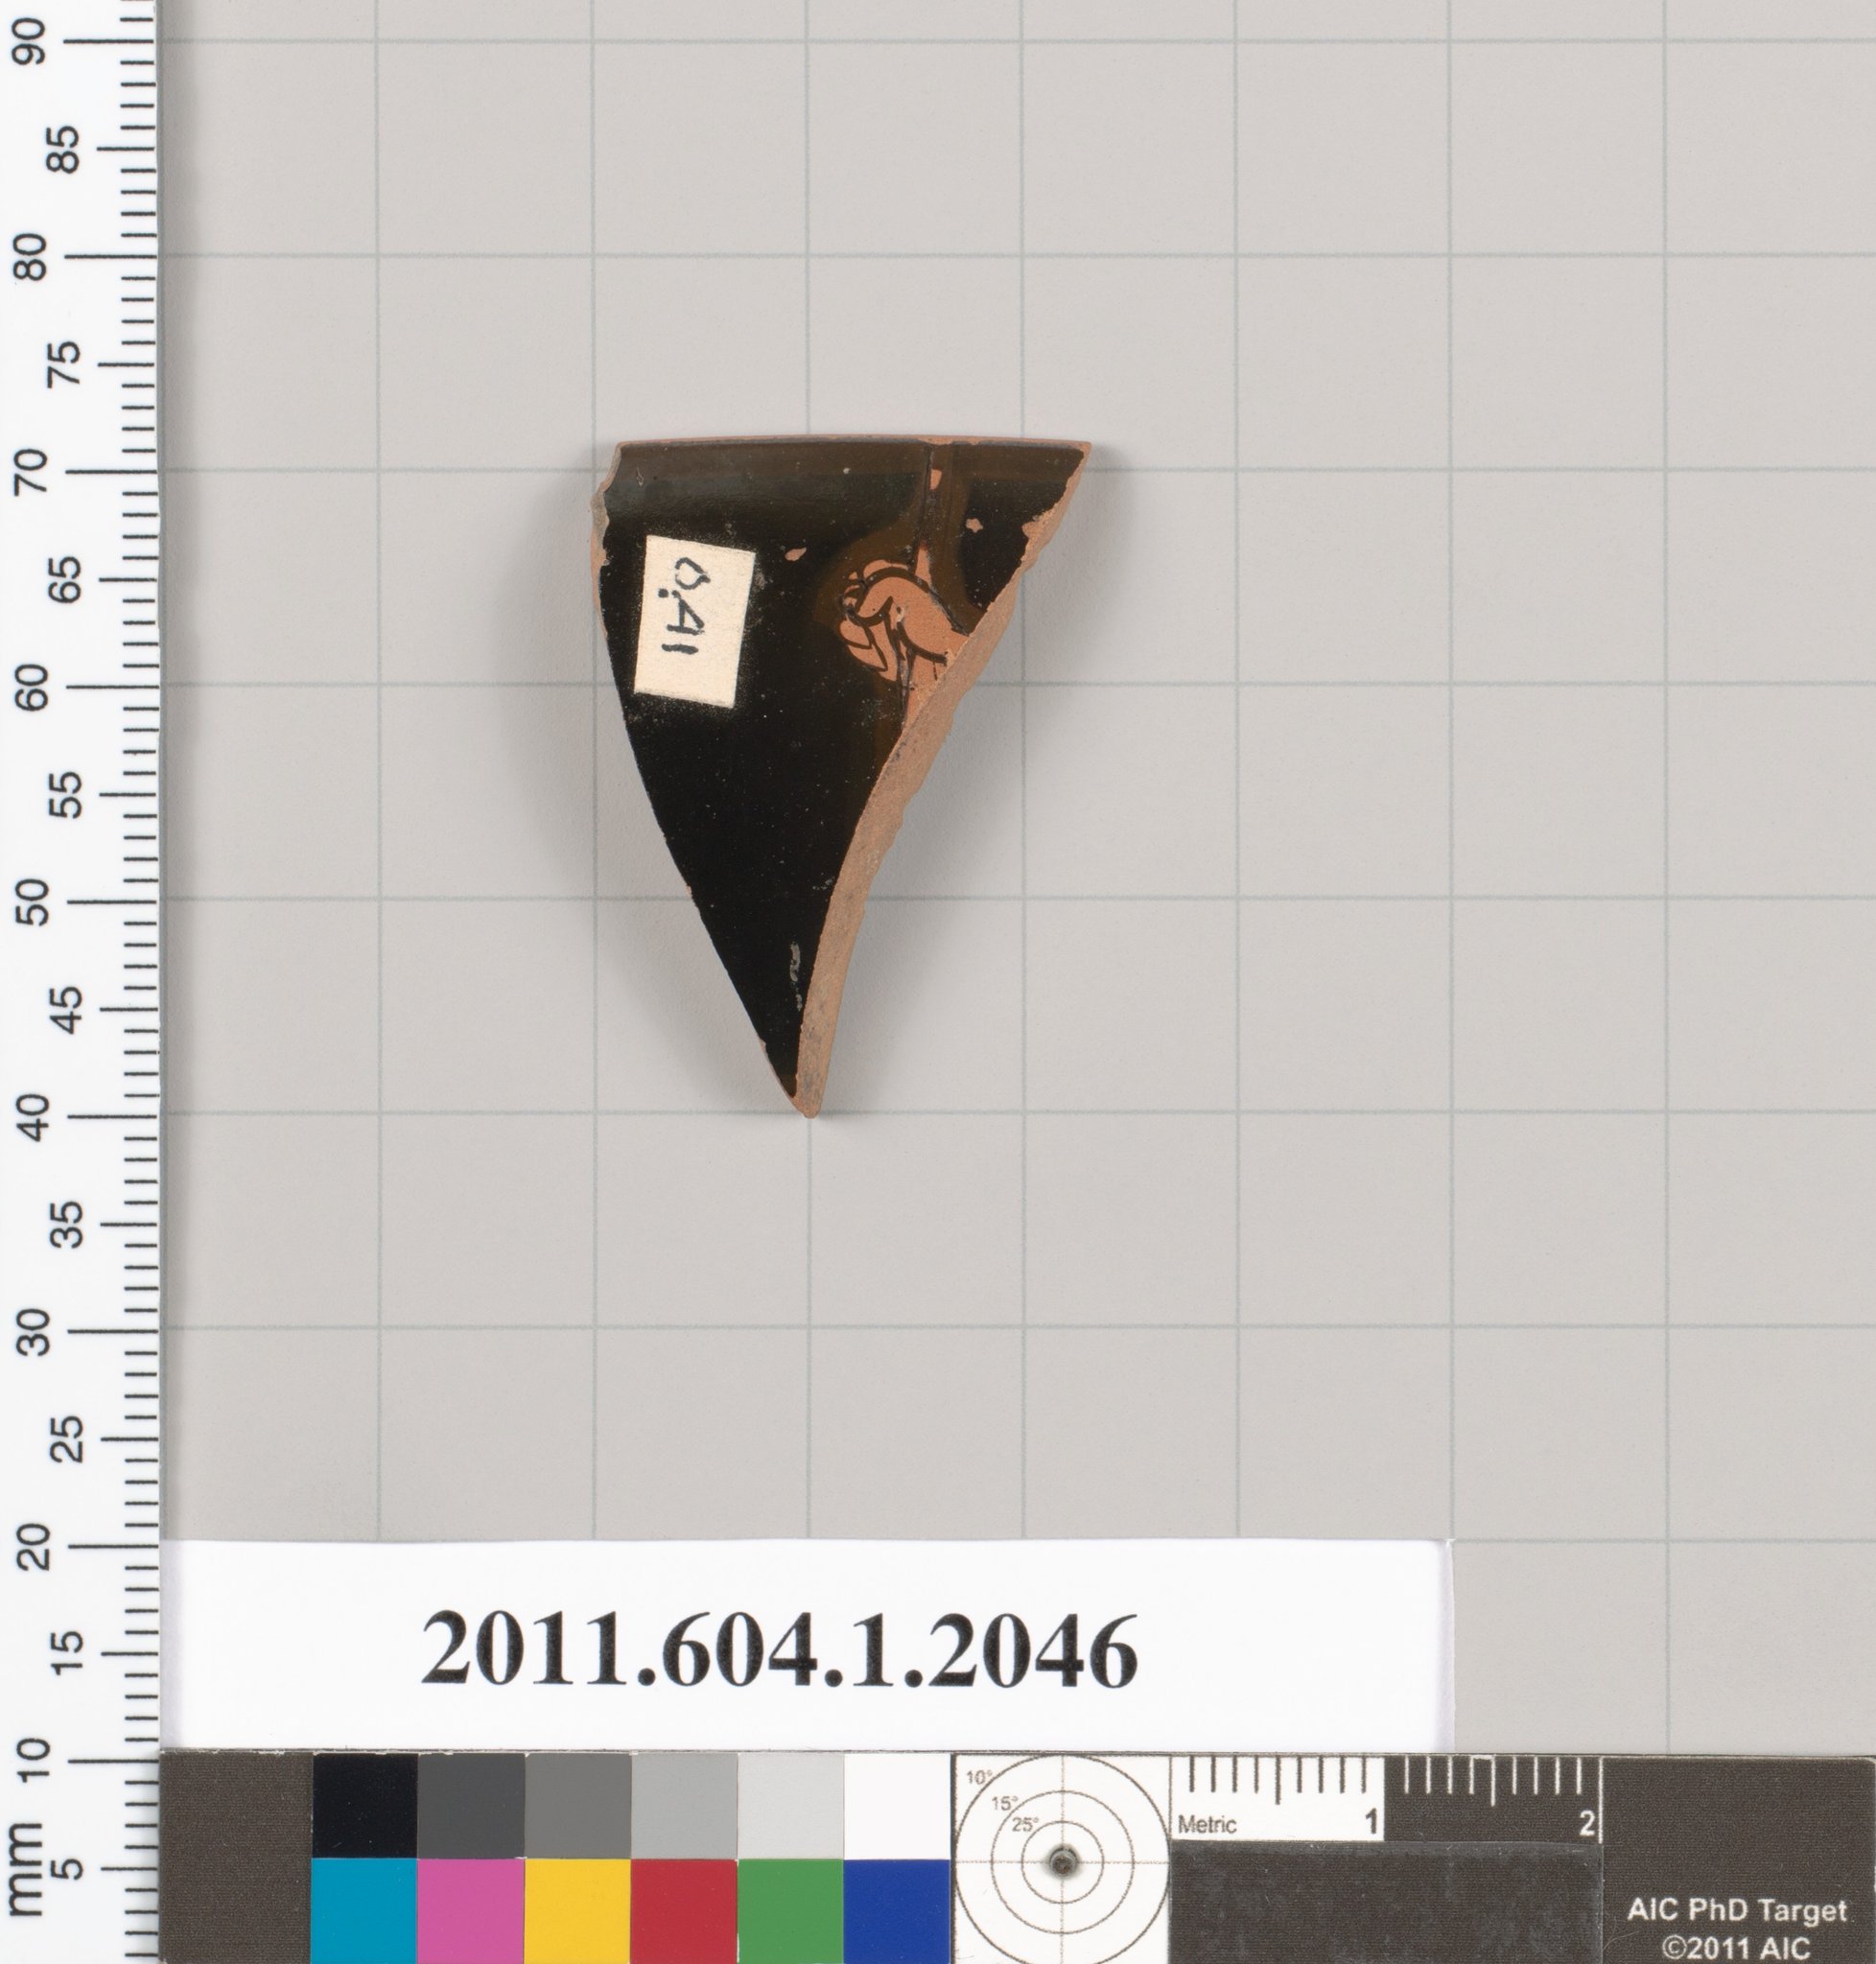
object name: kylix fragment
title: Terracotta rim fragment of a kylix (drinking cup)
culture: greek, attic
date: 500-470 BCE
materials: terracotta